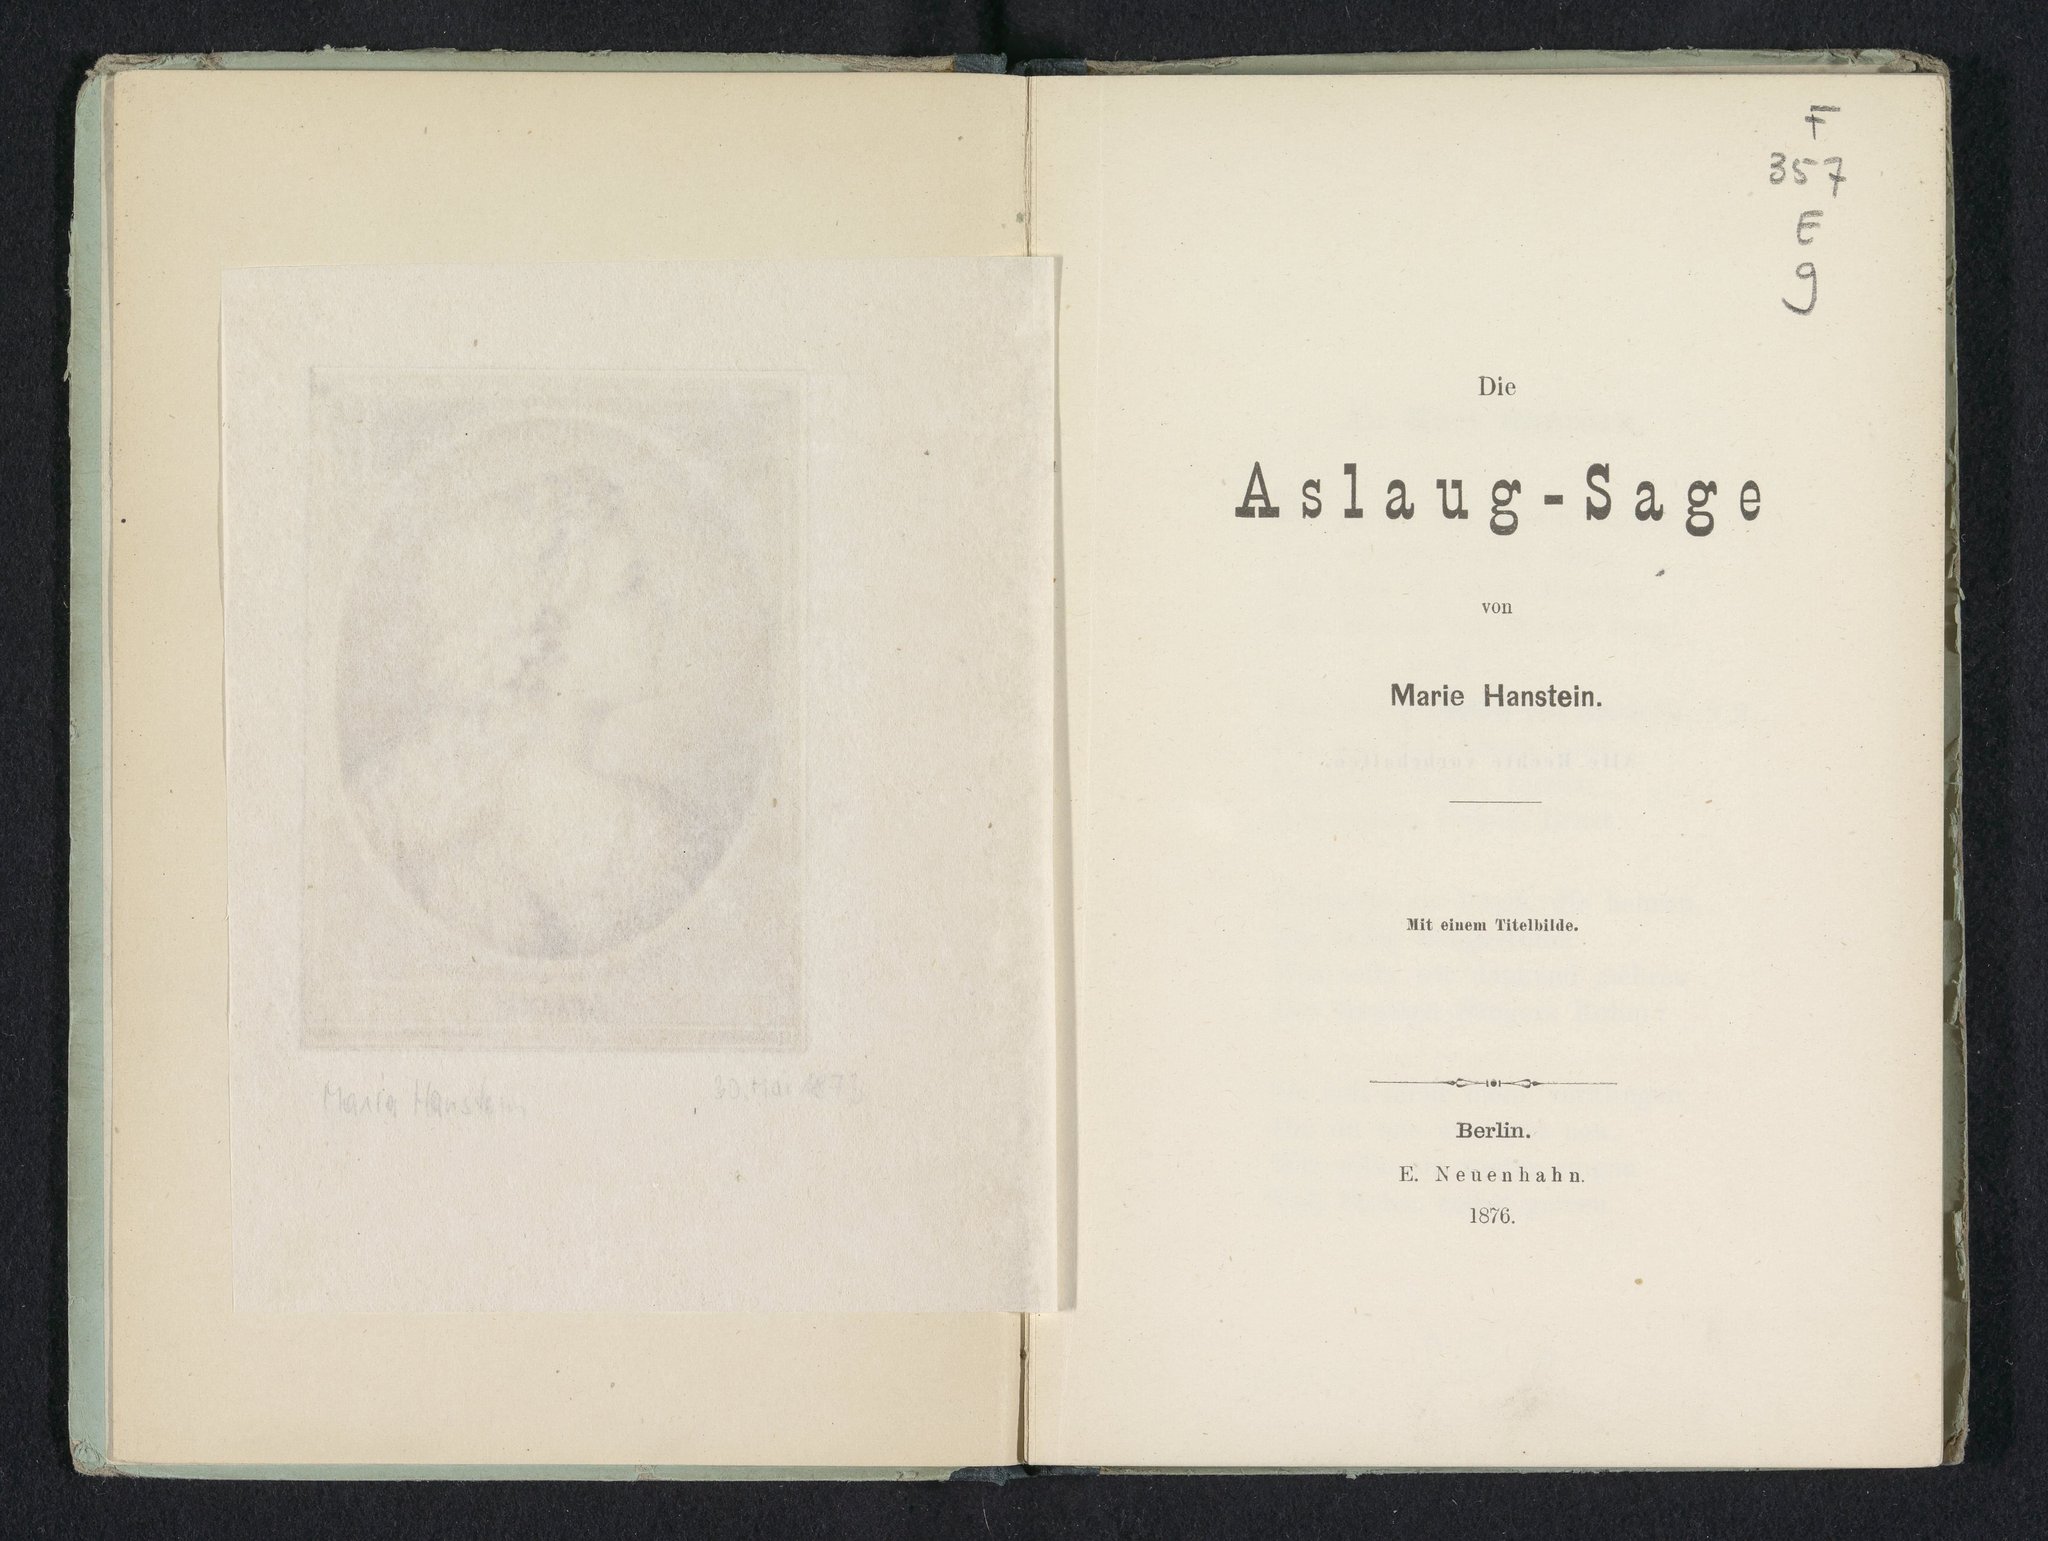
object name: book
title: Die Aslaug-Sage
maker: marie hanstein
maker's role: schrijver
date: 1876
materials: cardboard, linen, paper, photographic support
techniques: albumen print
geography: berlin